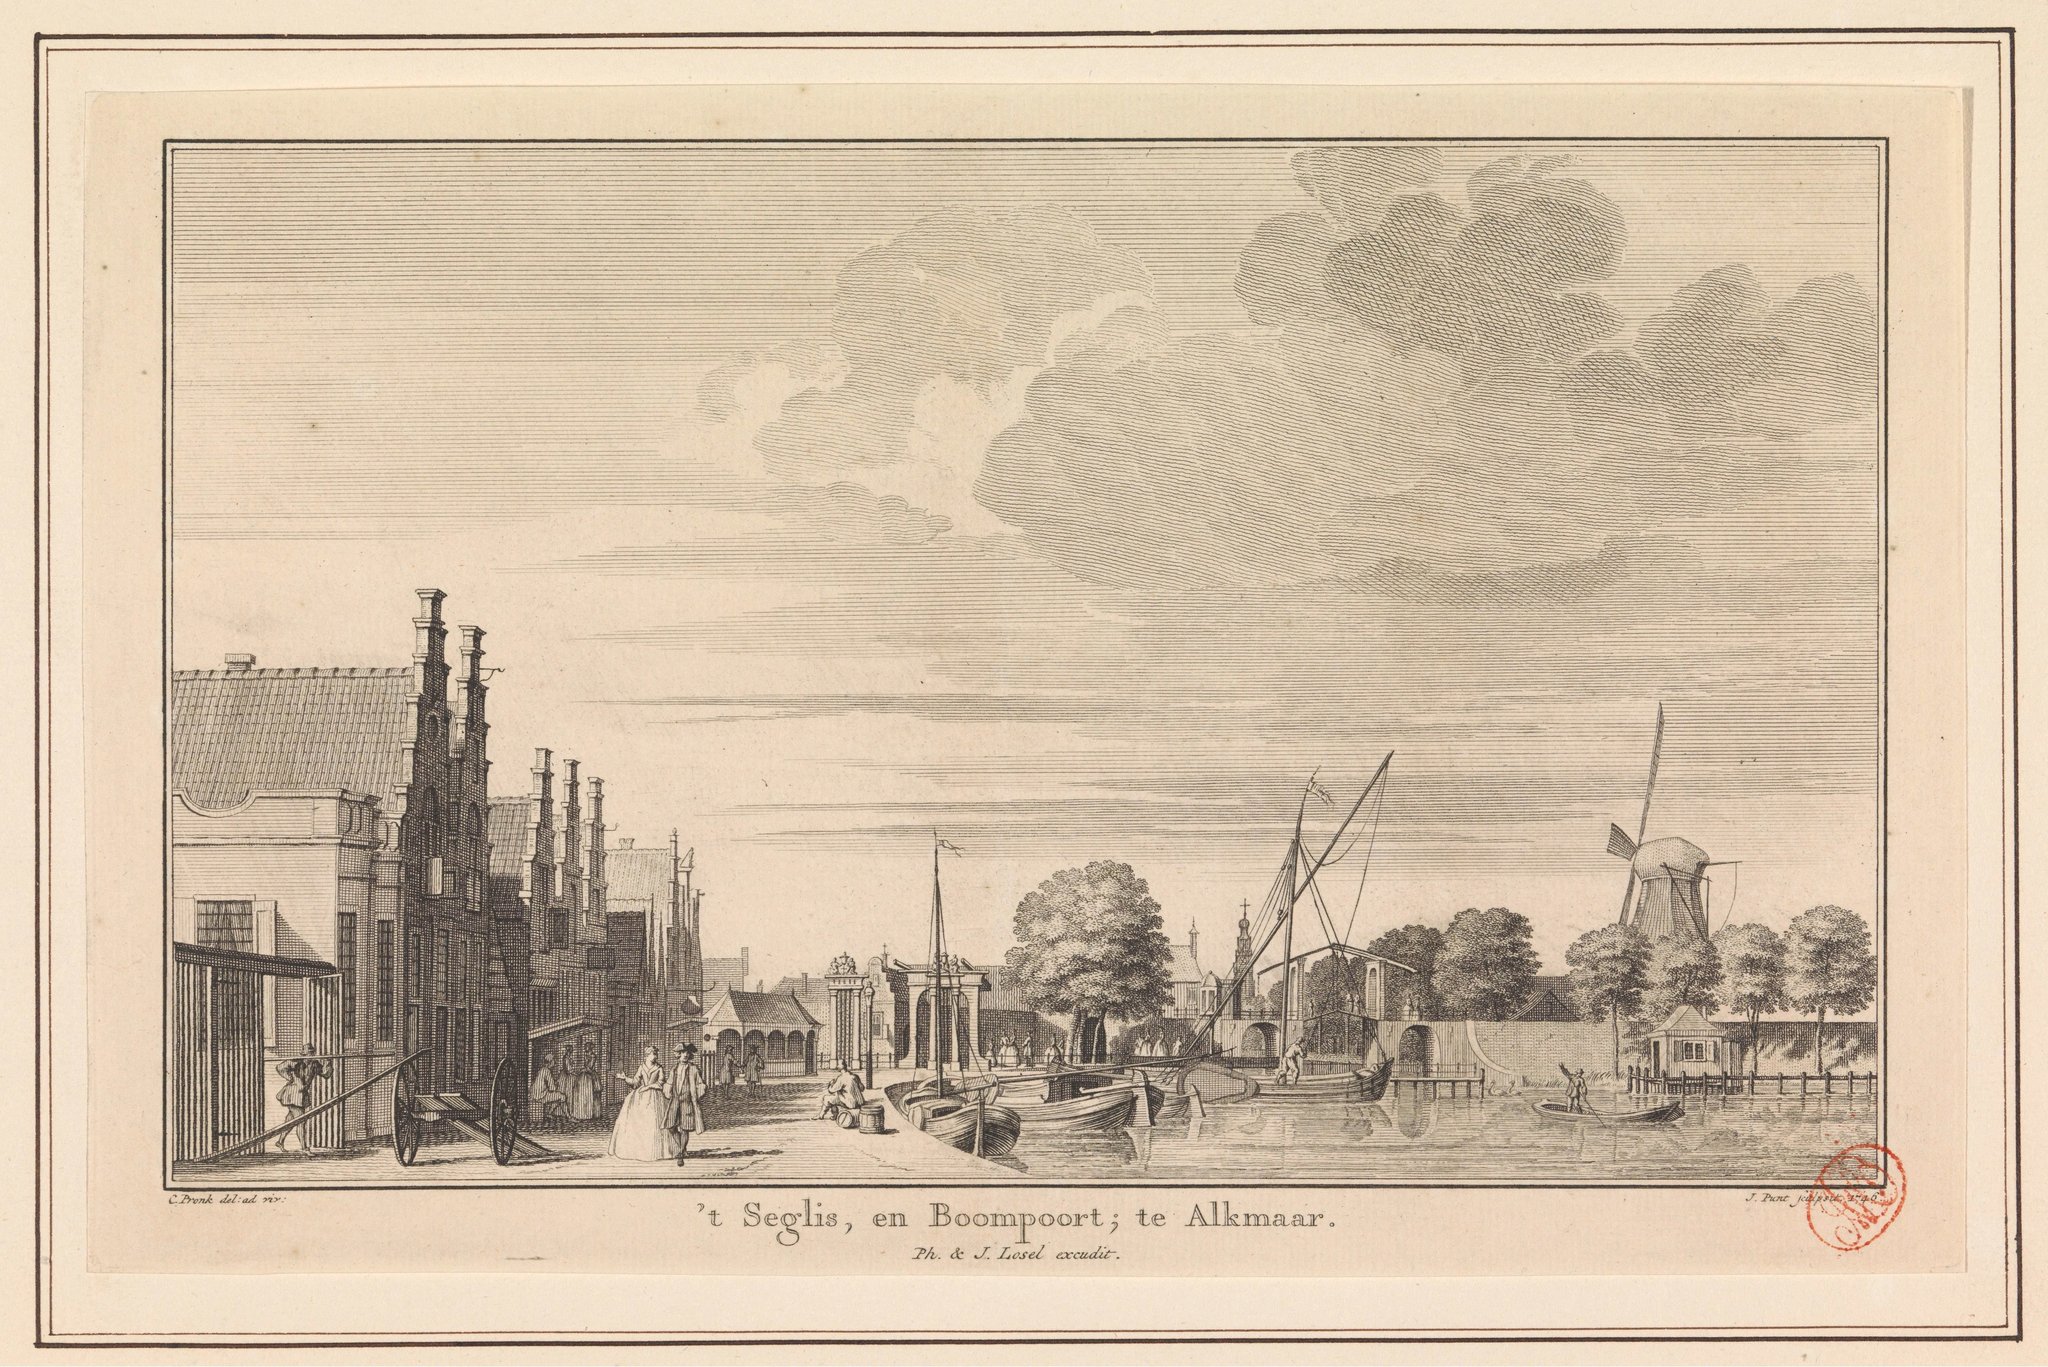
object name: print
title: 't Seglis, en Boompoort; te Alkmaar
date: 1746-1747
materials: paper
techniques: engraving, etching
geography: rotterdam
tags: sailing-ship, sailing-boat, rowing-boat, canoe, etc., bridge, windmill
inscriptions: collector's mark: Lugt 195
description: Prent gebruikt in: Boomkamp, Gysbert. Alkmaer en deszelfs geschiedenissen uit de nagelatene papieren van Simon Eikelenberg (...). Rotterdam: Philippus en Jakobus Losel, 1747. Zie ook RP-P-1905-659 en RP-P-AO-9A-4.